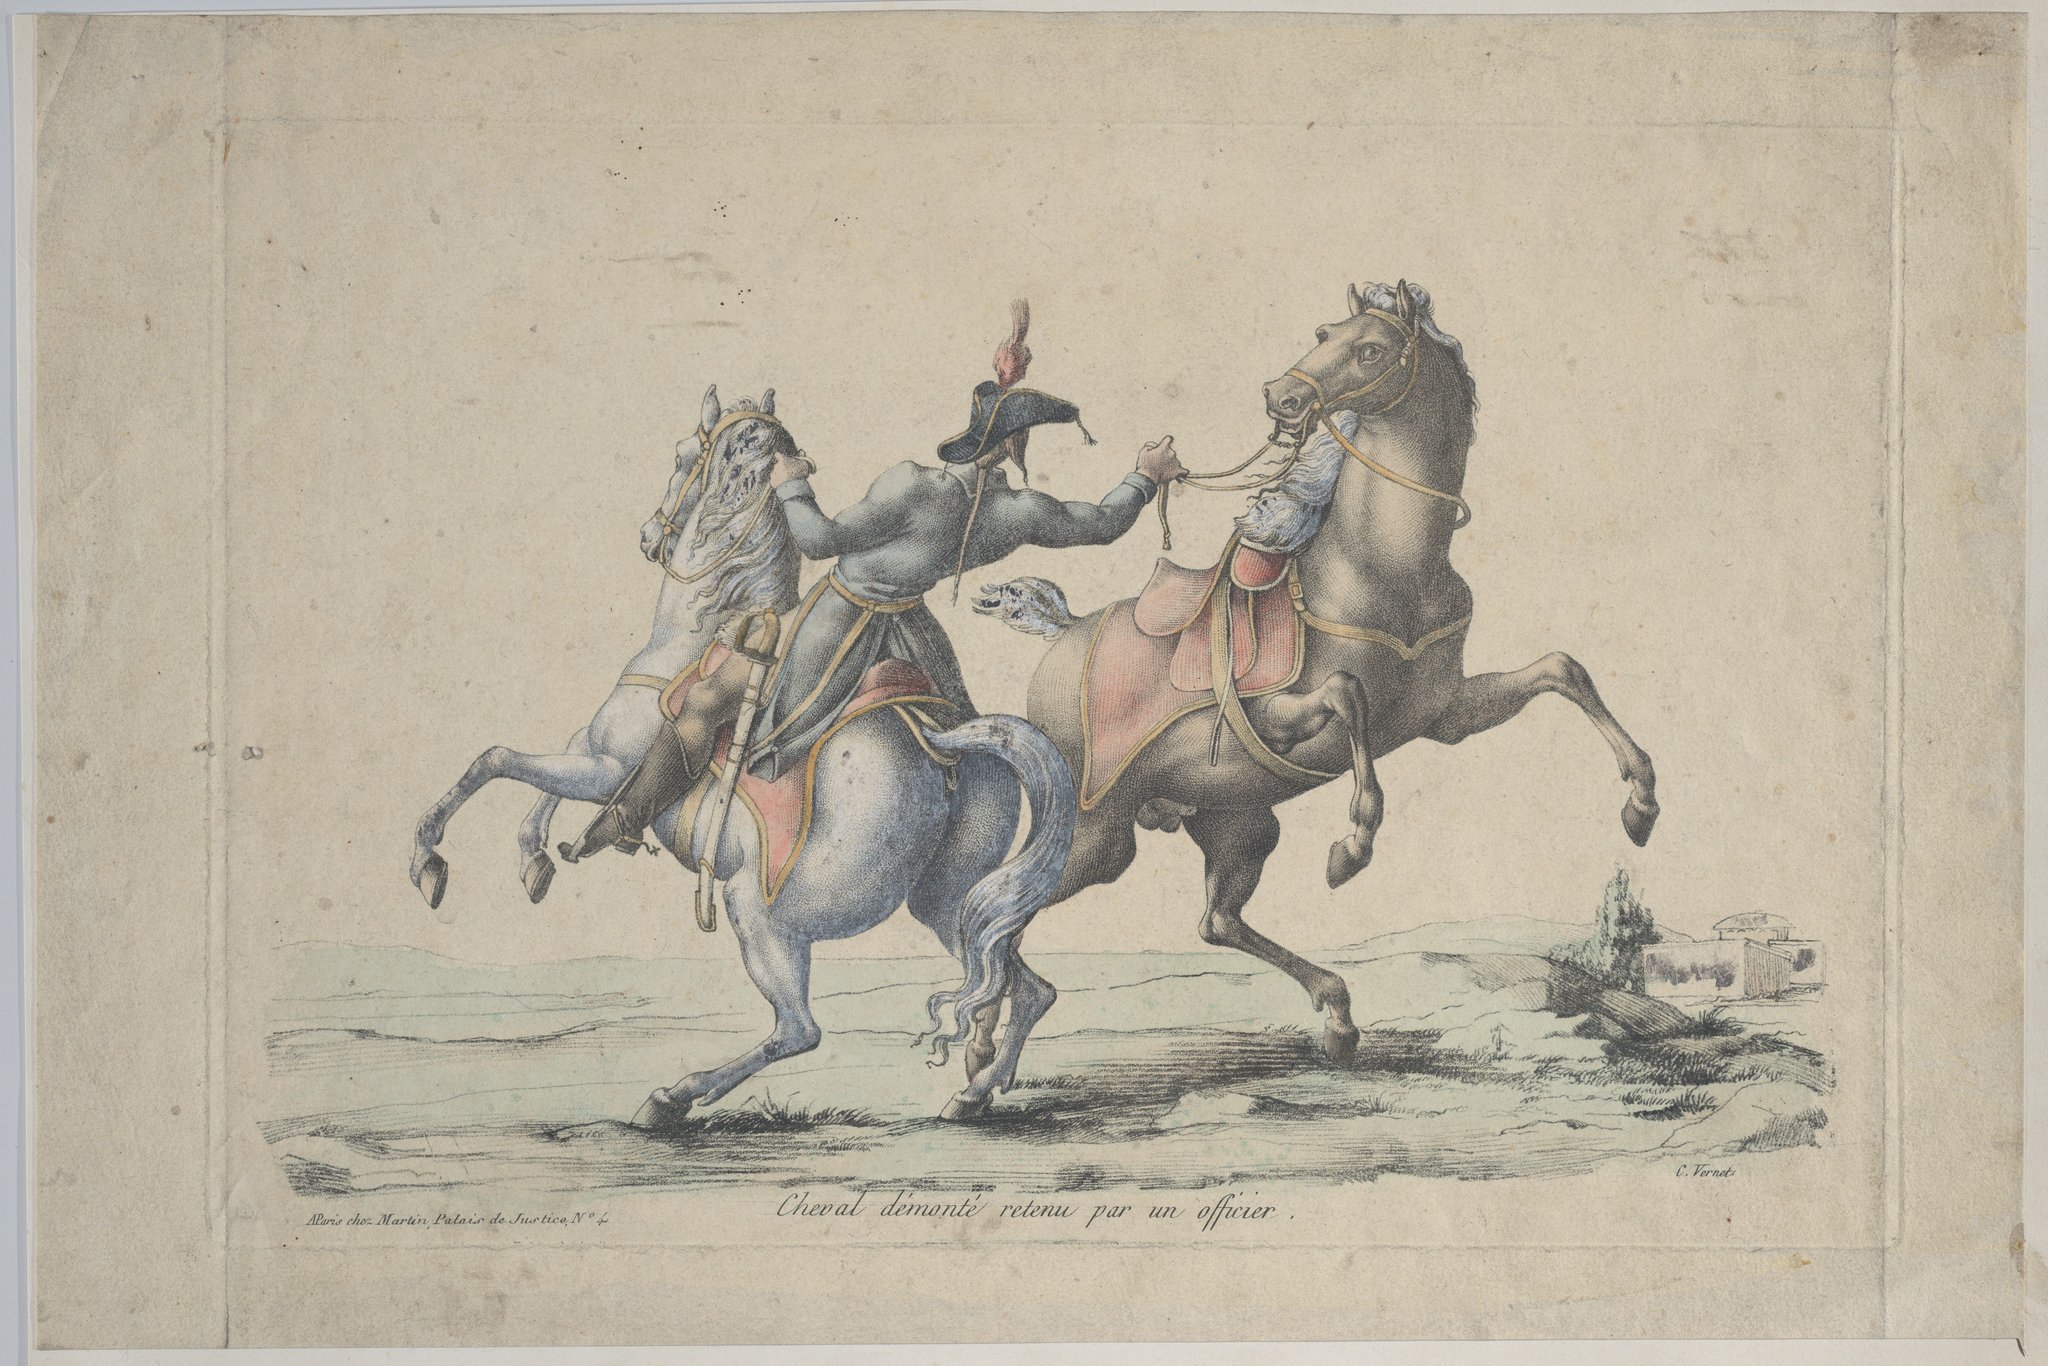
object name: print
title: A Dismounted Horse Reined in by an Officer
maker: carle vernet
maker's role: artist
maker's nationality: french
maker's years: 1758-1836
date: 1770-1836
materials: paper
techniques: hand coloring, lithograph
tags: men,horses